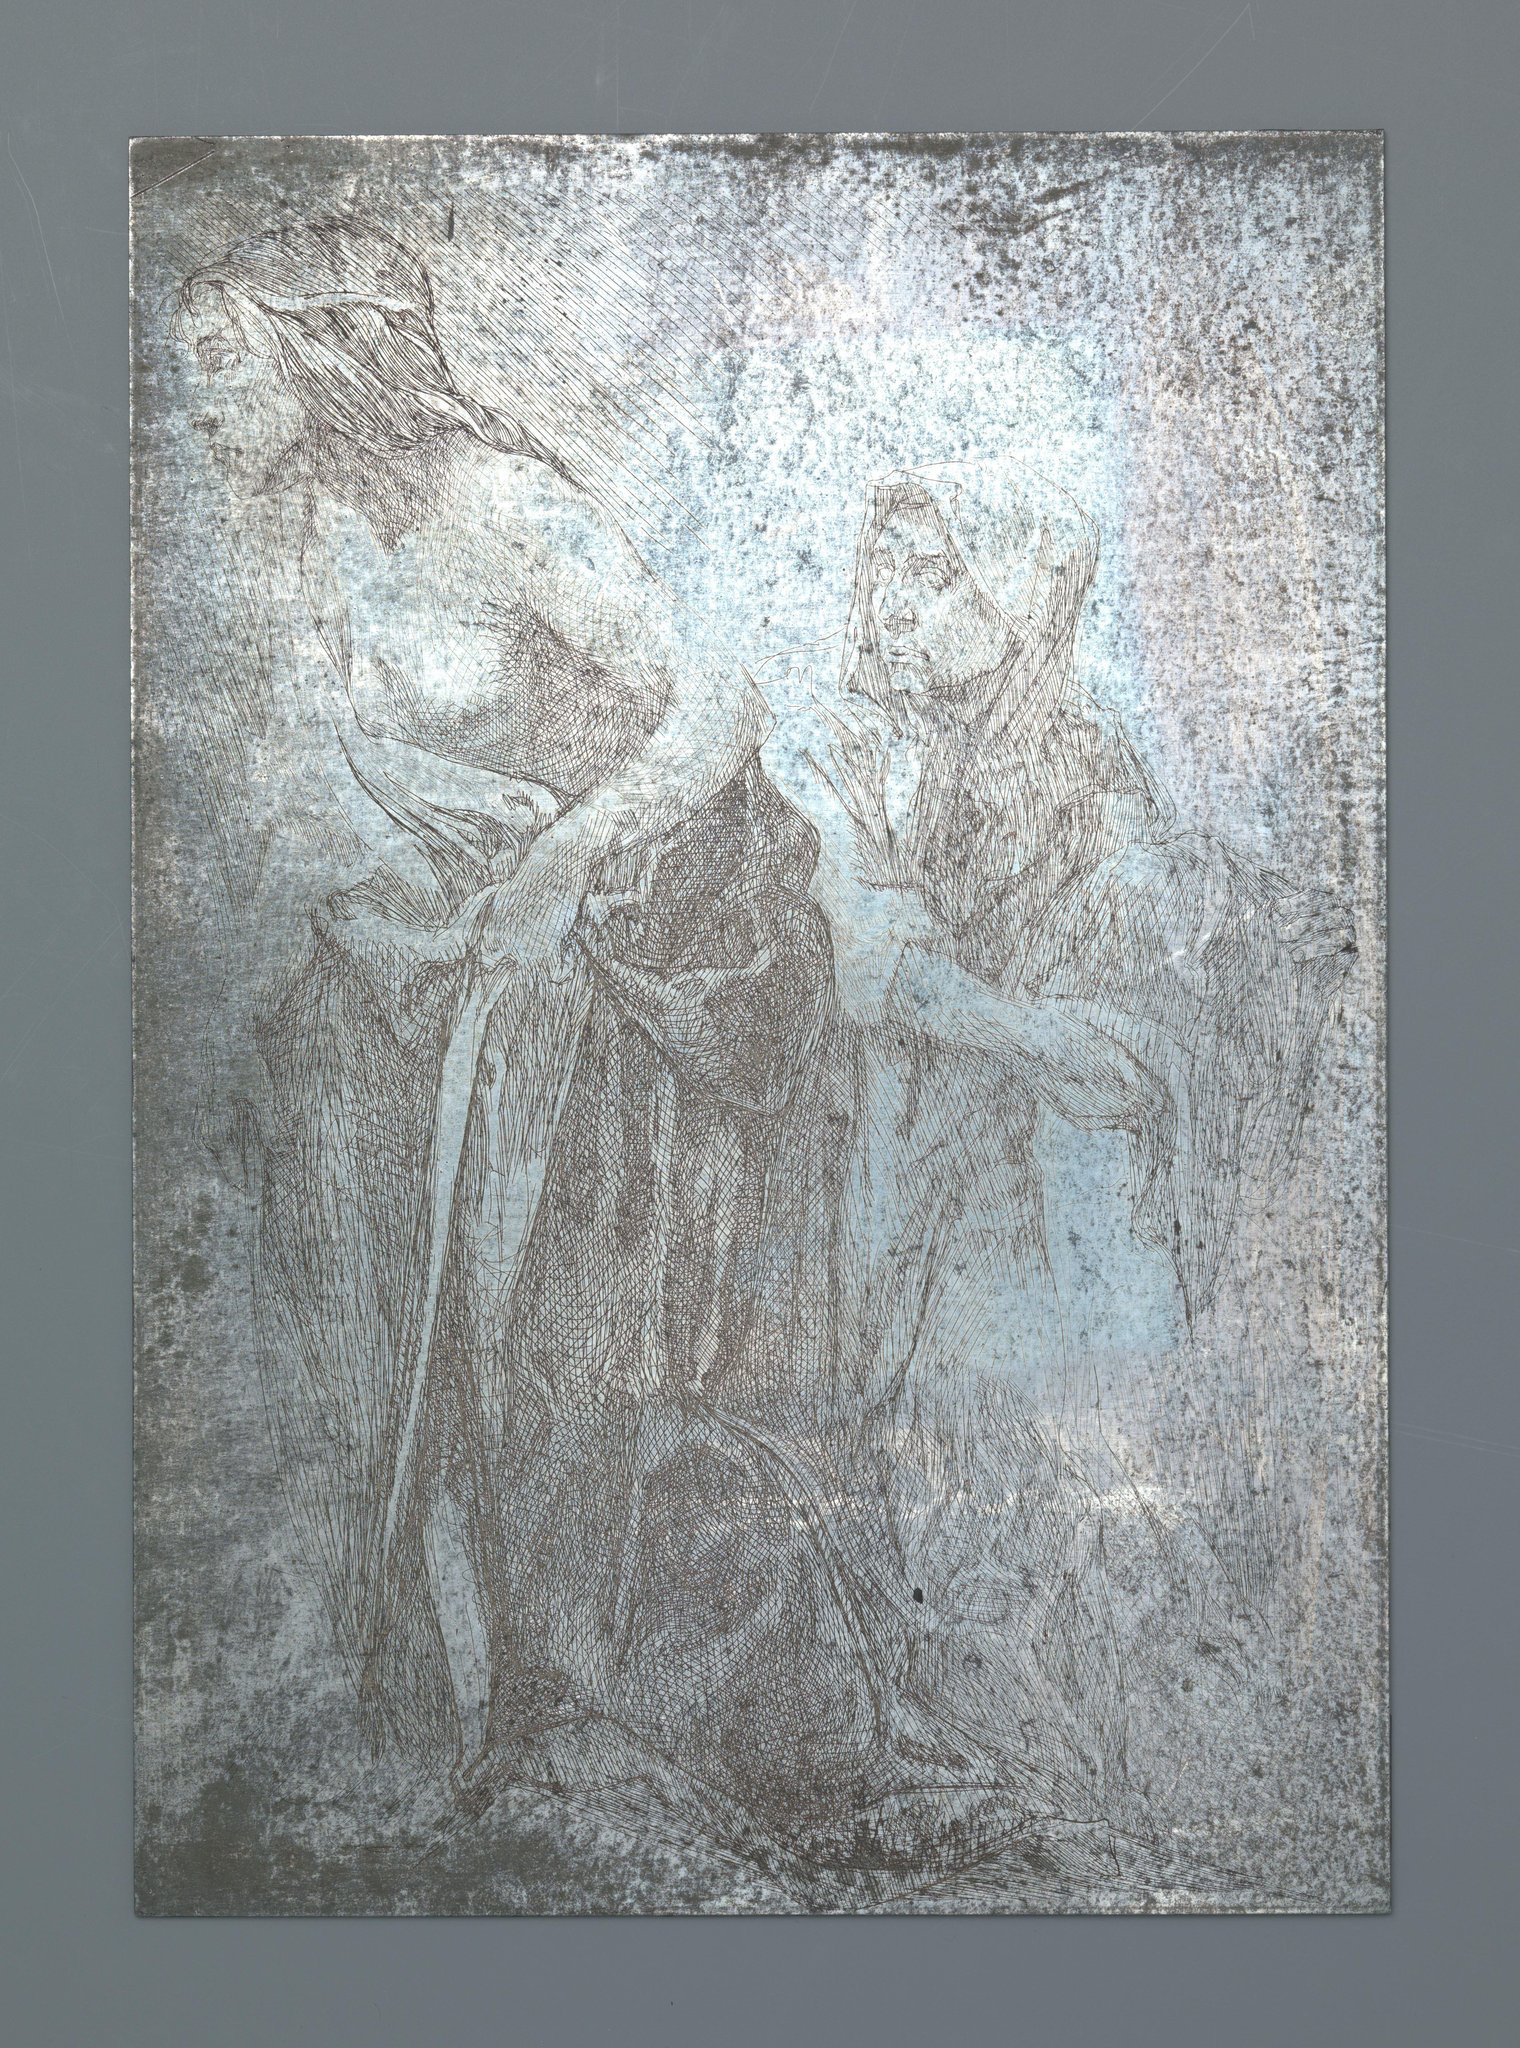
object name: zinkplaat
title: Judit en dienstmeid met het hoofd van Holofernes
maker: johannes josephus aarts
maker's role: draughtsman, print maker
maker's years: 1871-1934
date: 1881-1934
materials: zinc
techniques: etching